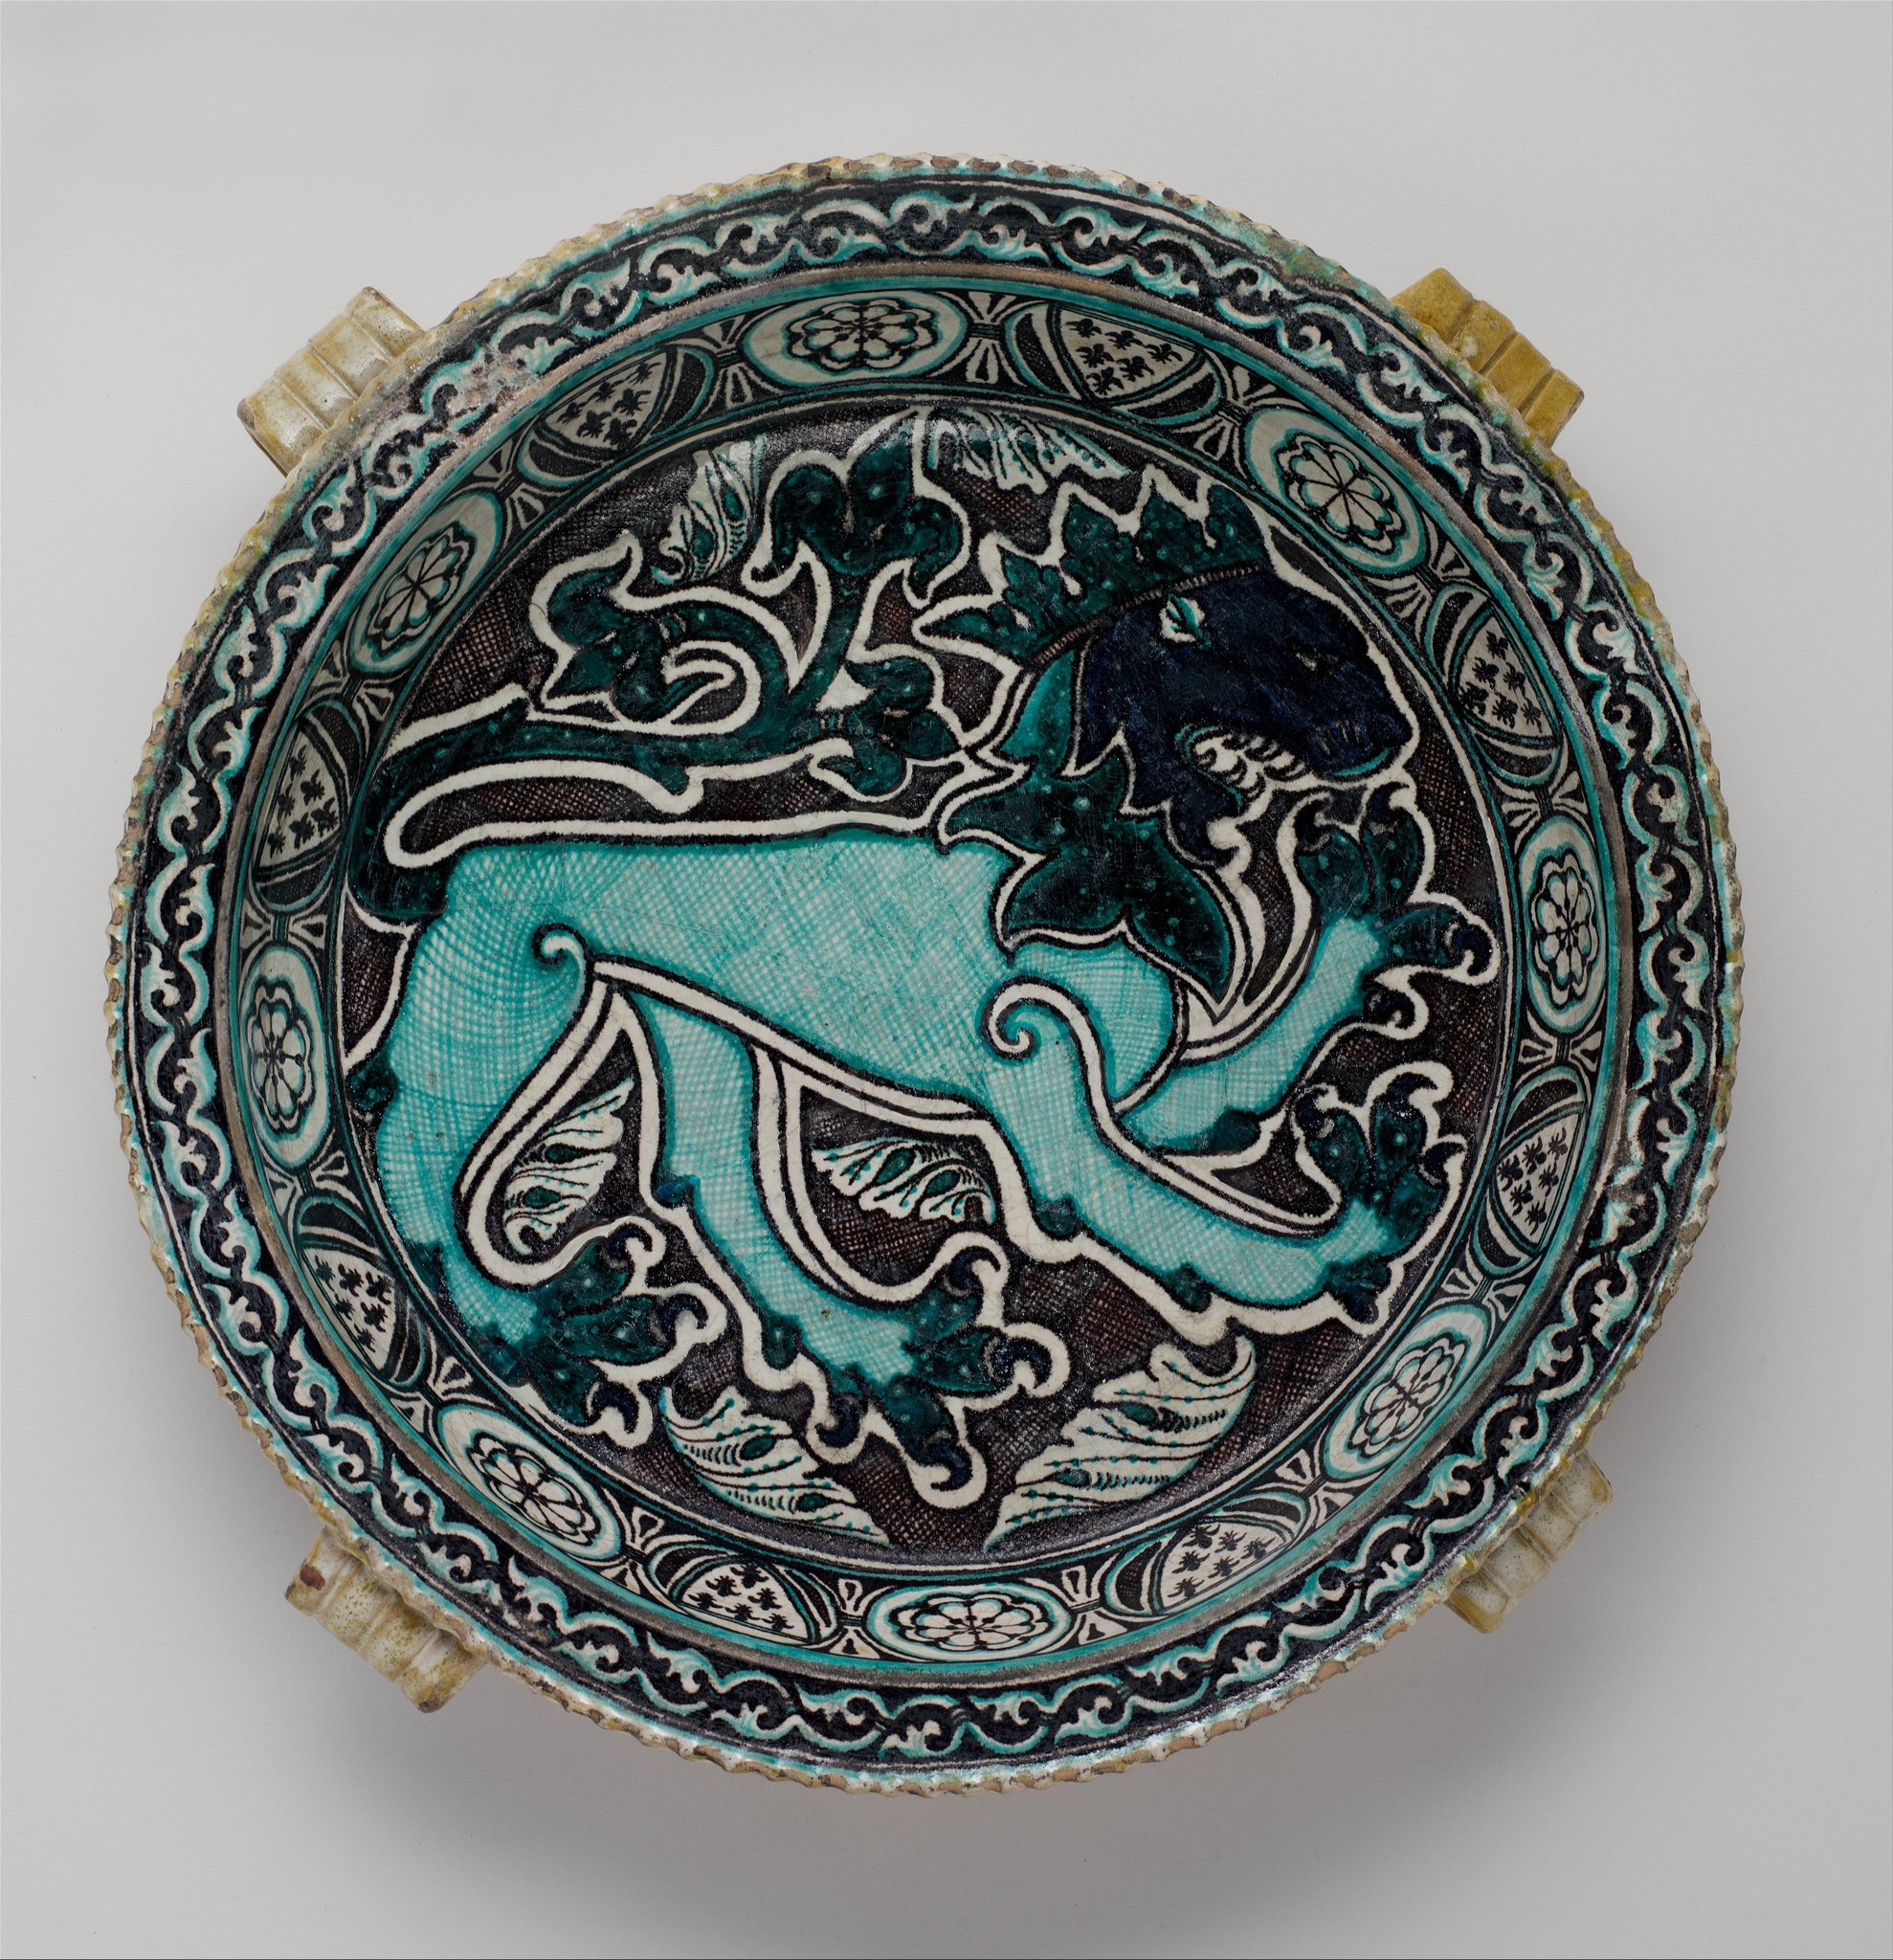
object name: dish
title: Dish with Lion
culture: italian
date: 1367-1400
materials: earthenware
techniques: glazing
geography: italy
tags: lions